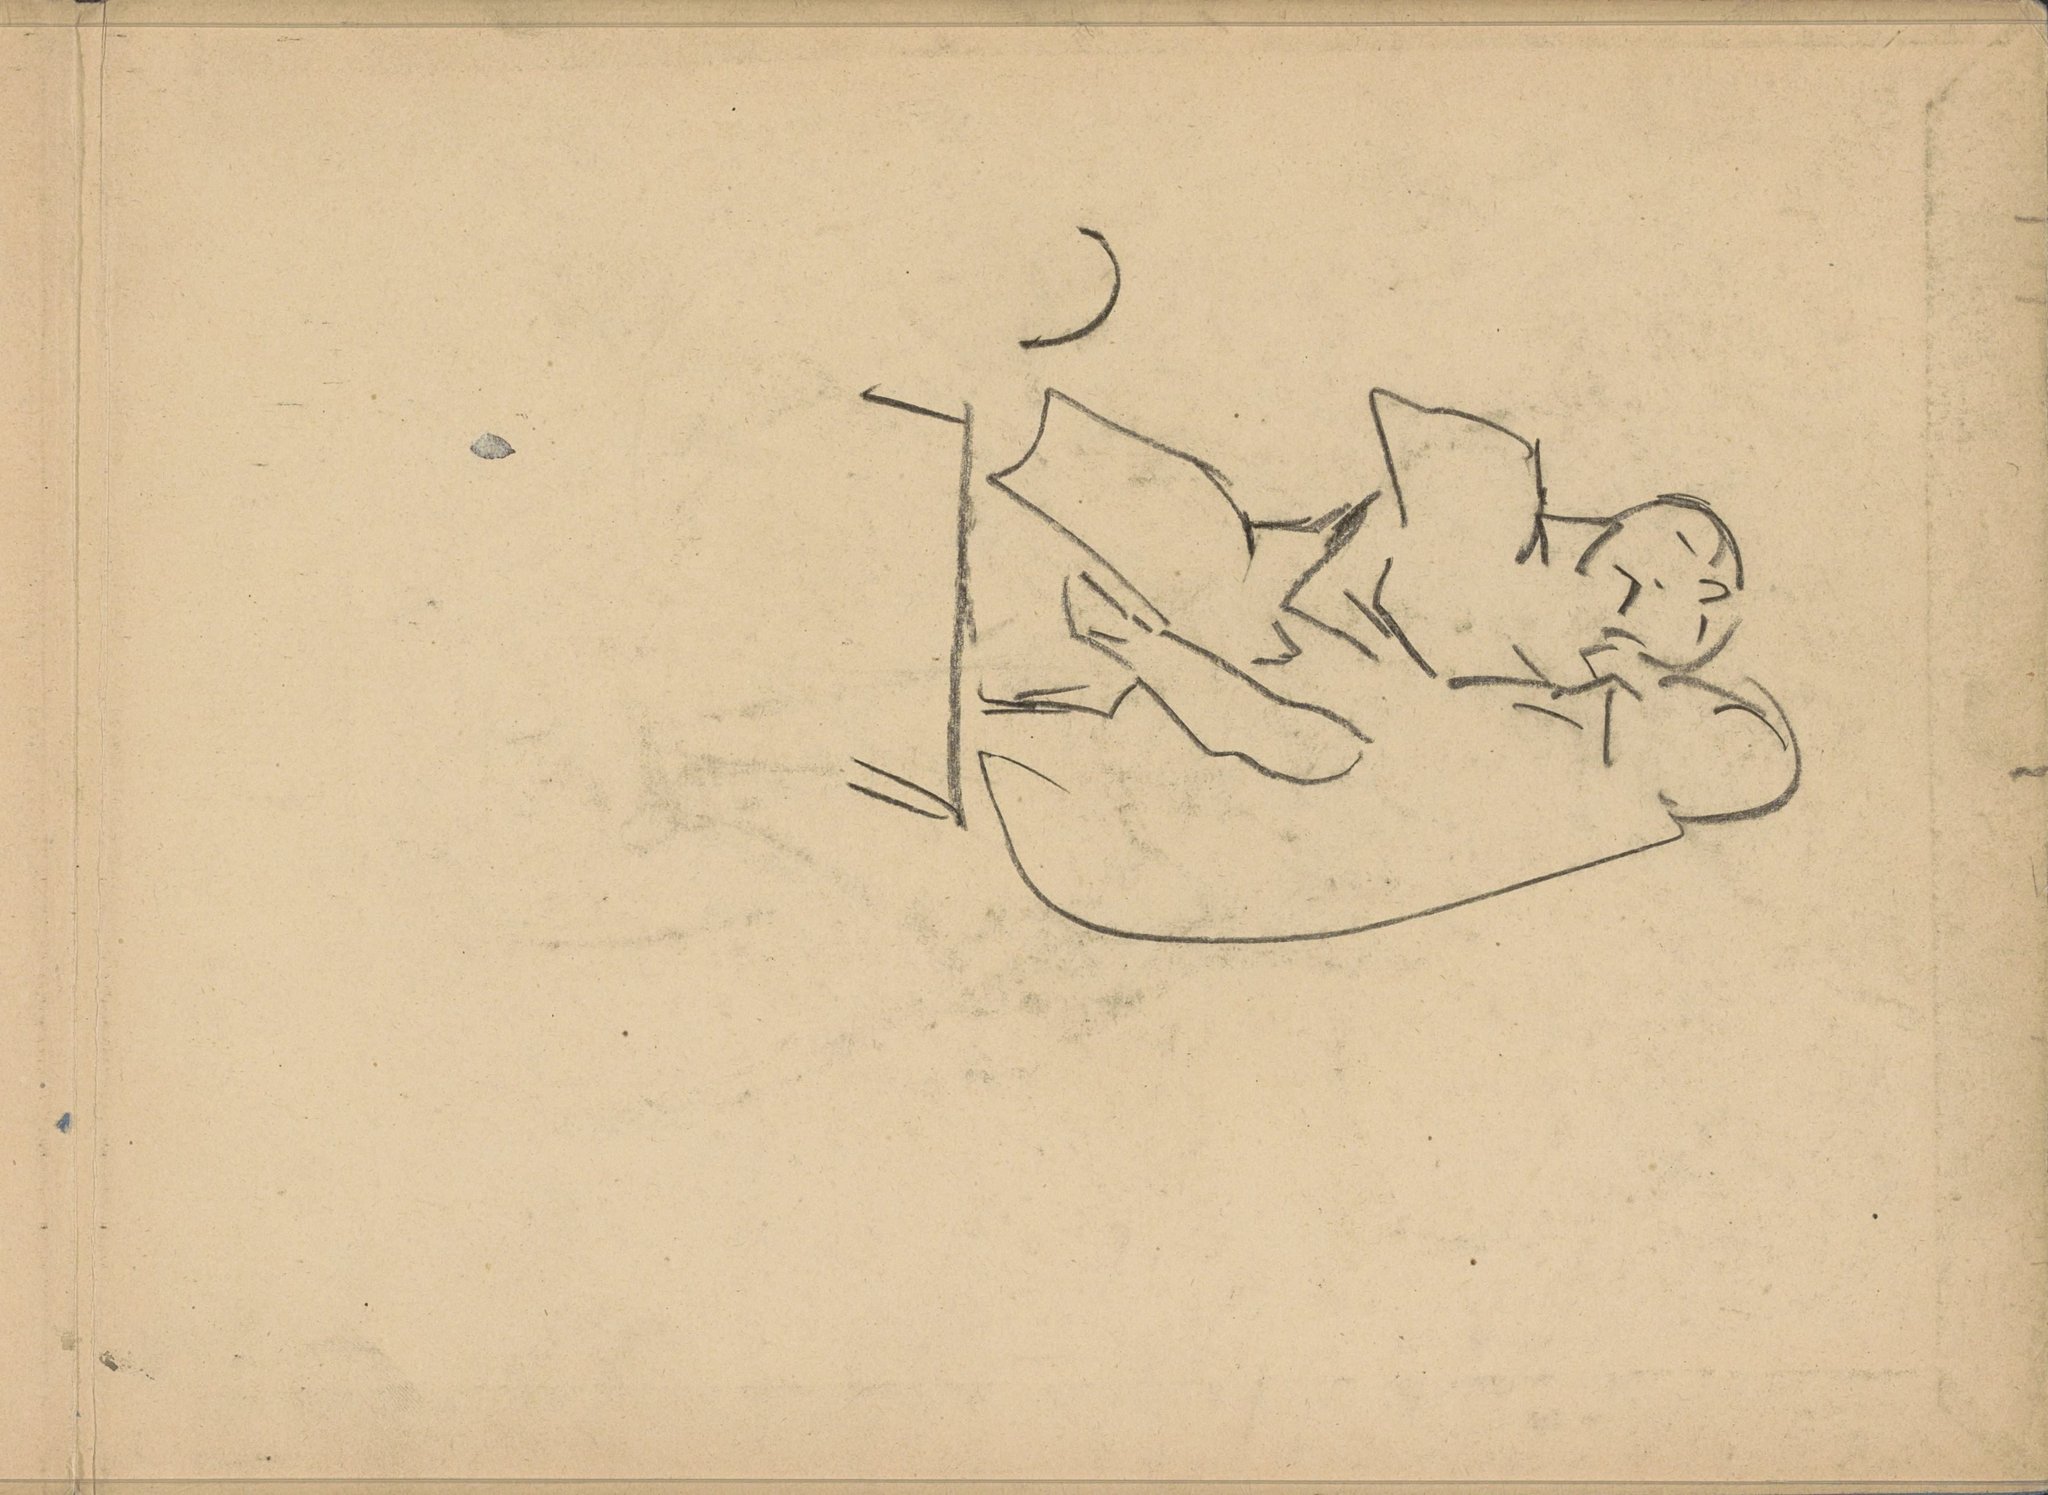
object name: sketchbook leaf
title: Figuurstudies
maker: isaac israels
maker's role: draughtsman, painter, print maker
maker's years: 1865-1934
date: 1875-1934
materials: chalk, paper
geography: the hague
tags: postures of the human figure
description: Schutblad B, achterste schutblad, uit schetsboek XXI met 19 bladen.